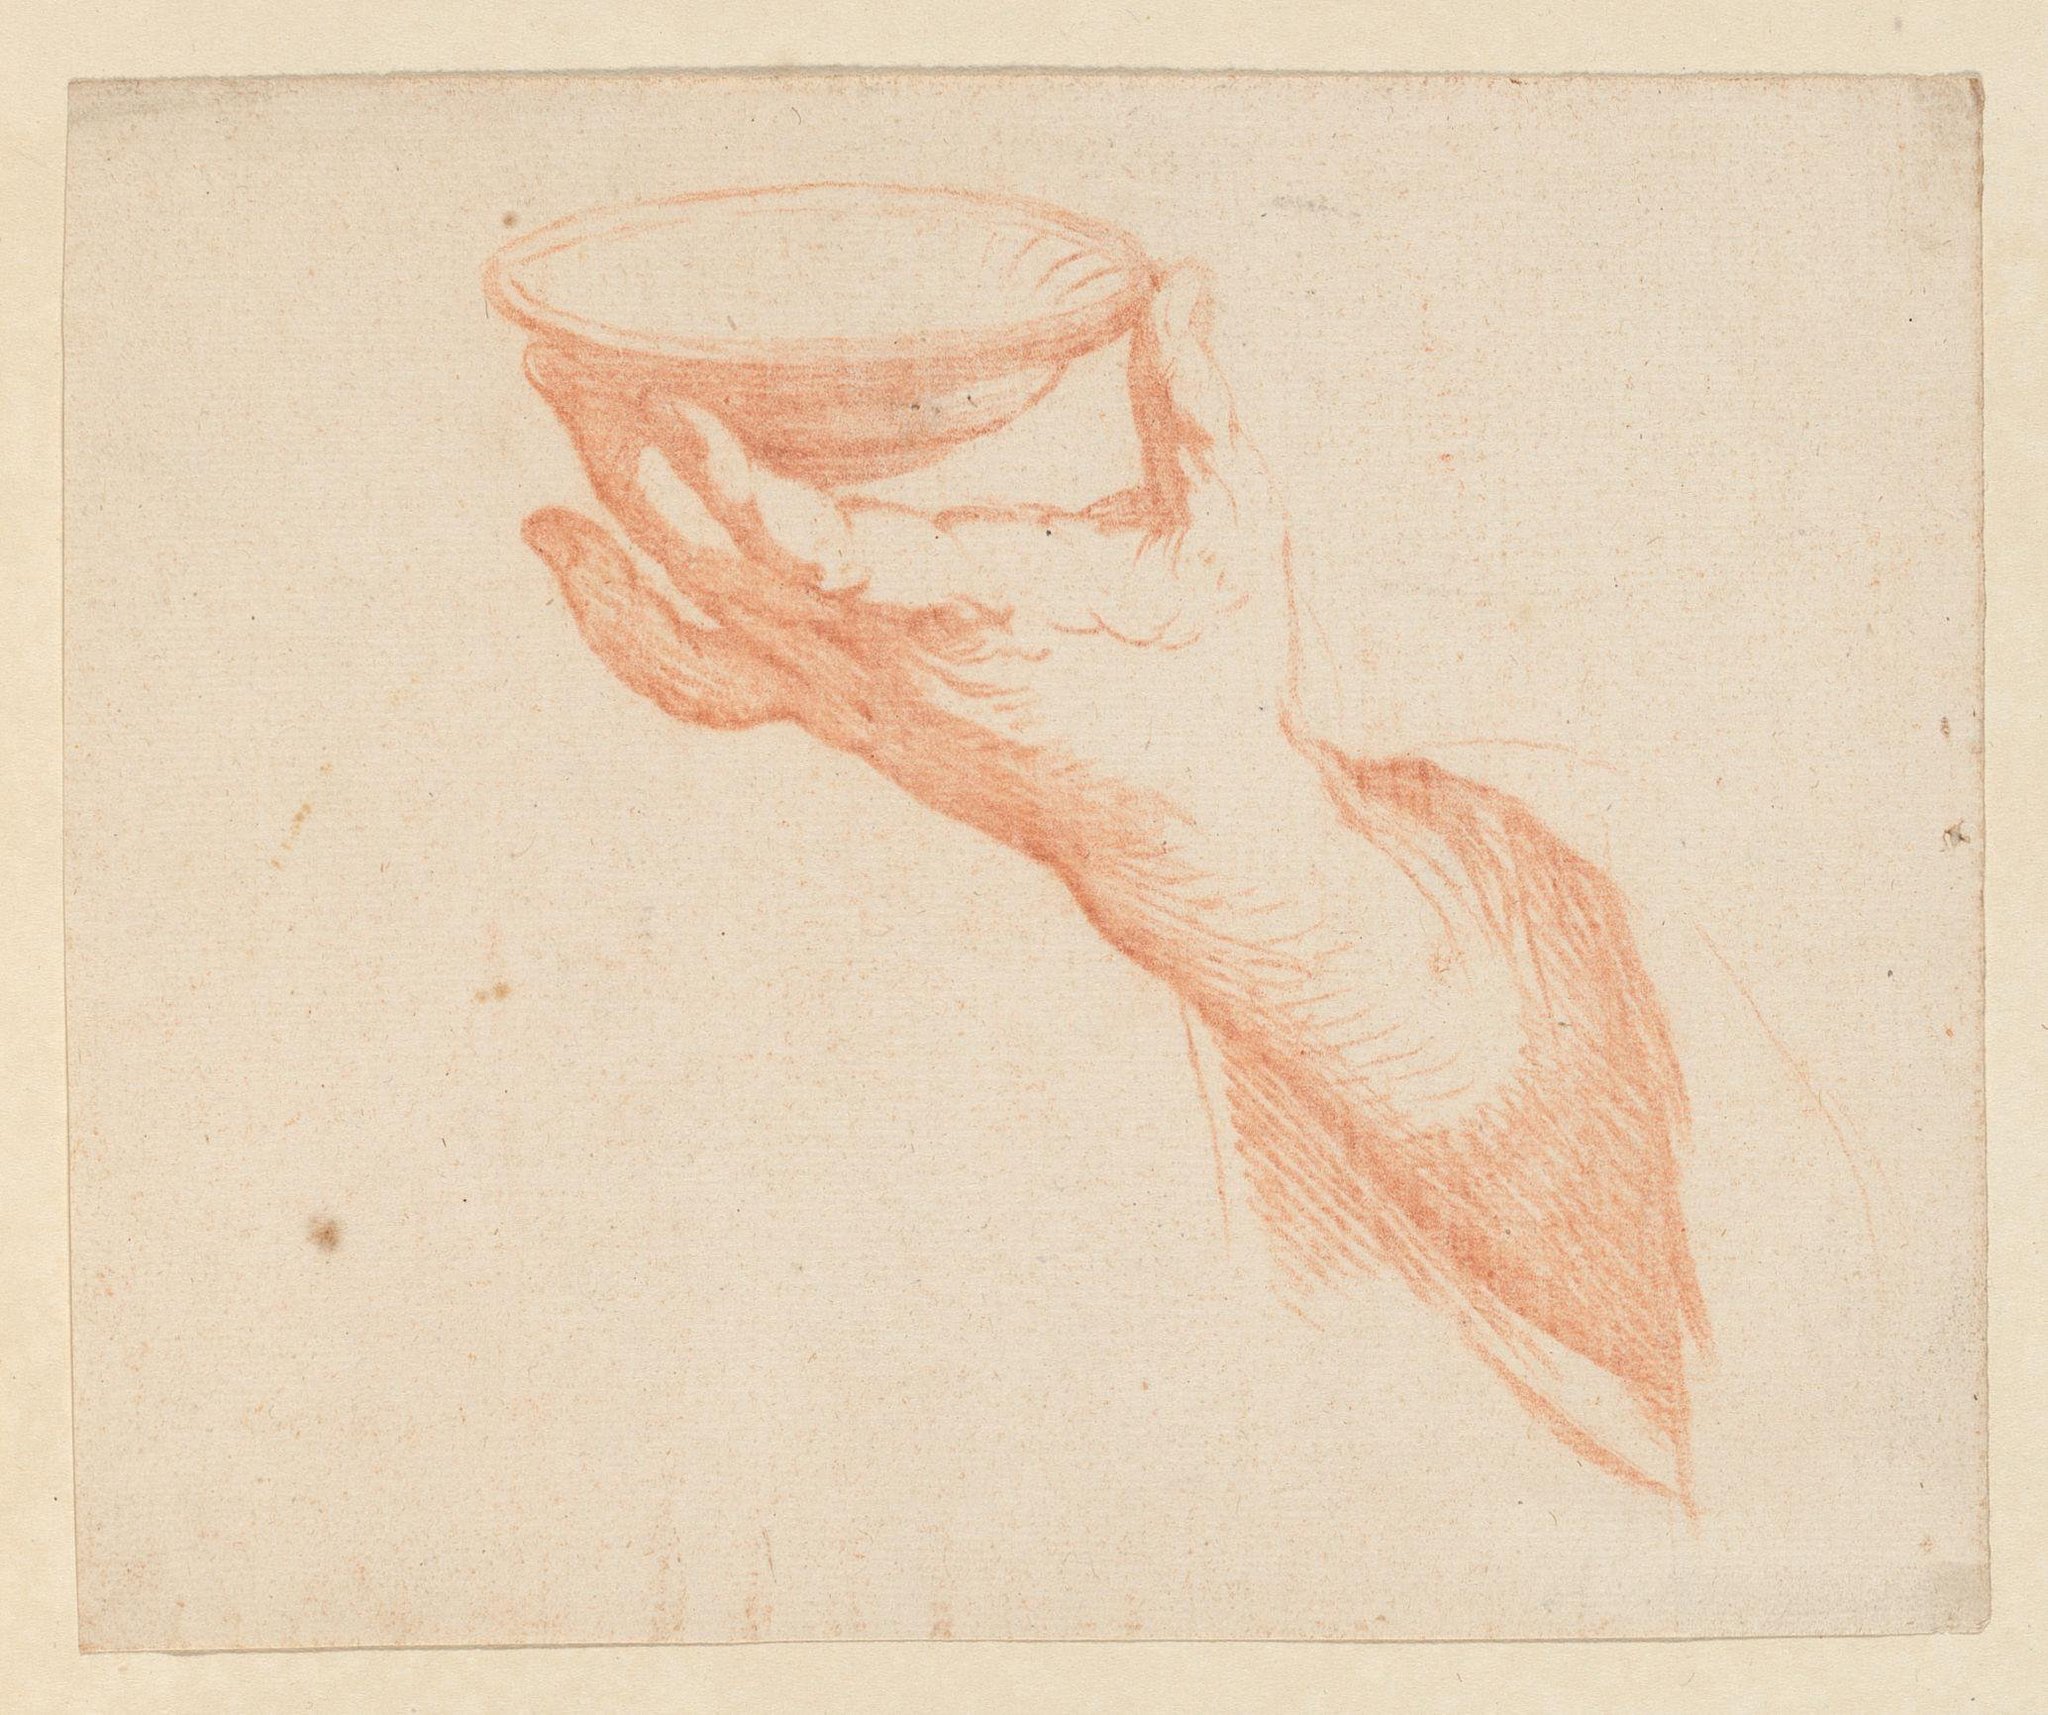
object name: album leaf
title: Studie van een hand met een nap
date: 1649-1723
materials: chalk, paper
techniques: pasting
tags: postures and gestures of hand and fingers, bowl